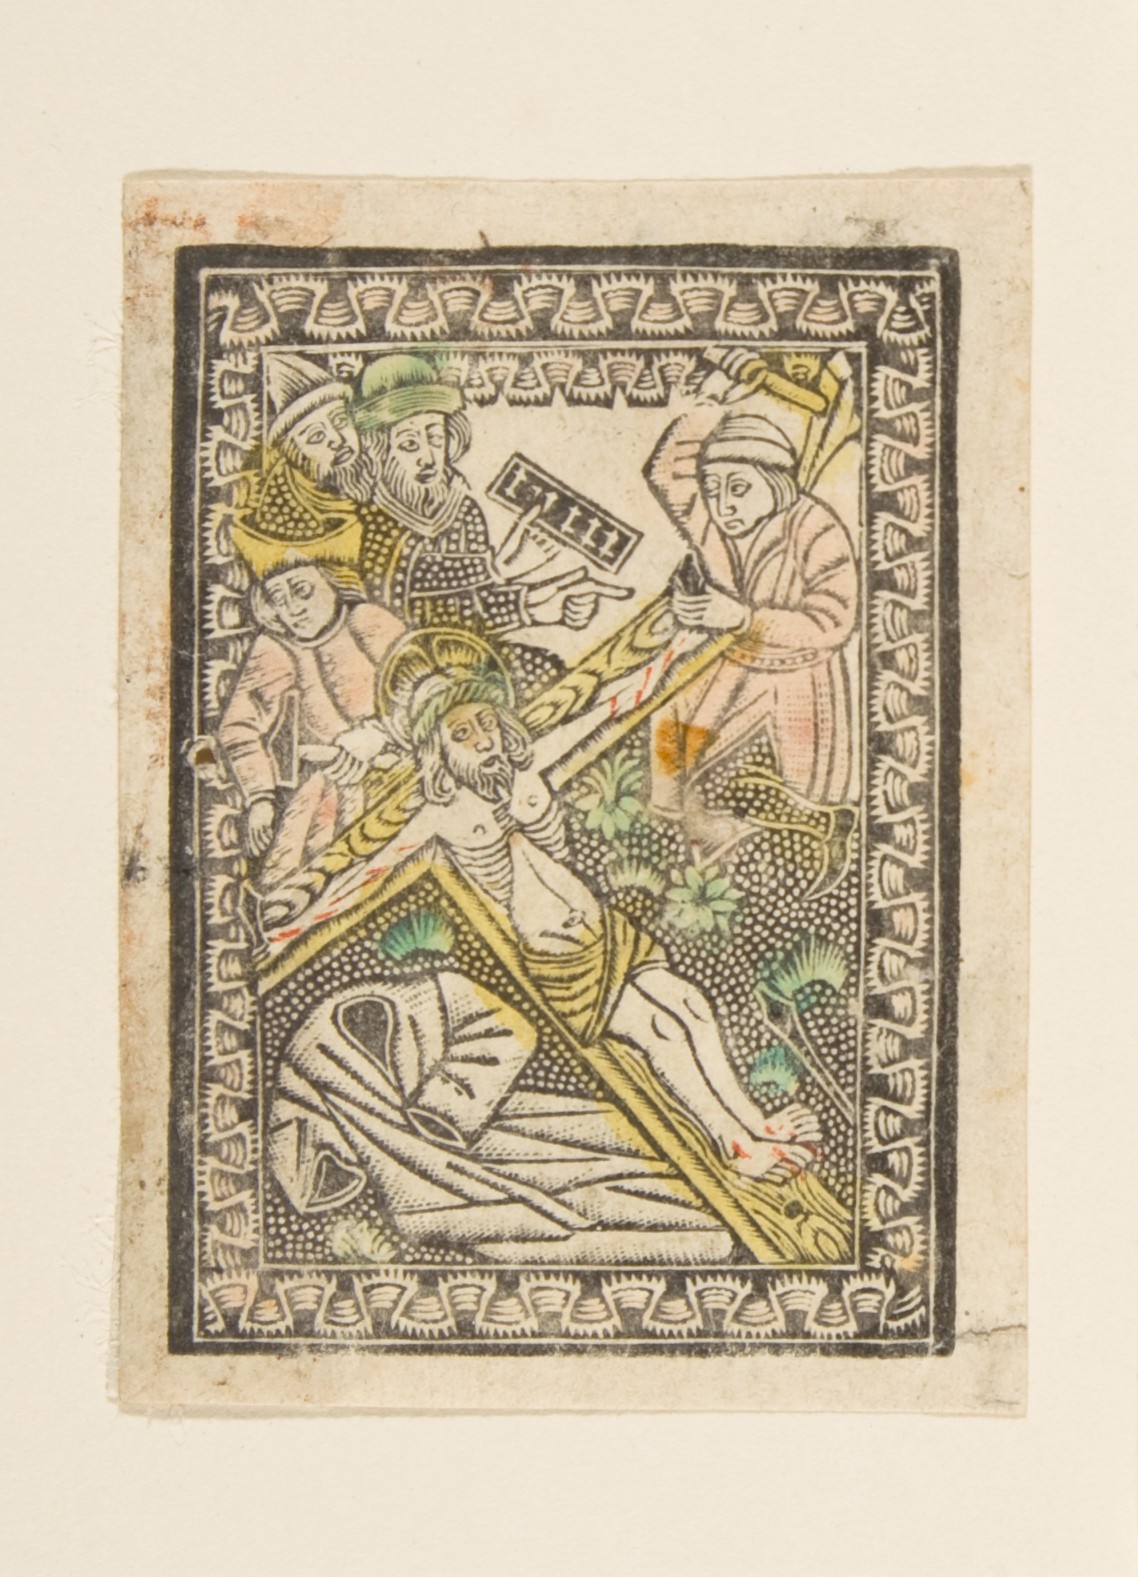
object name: print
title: Christ Nailed to the Cross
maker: anonymous, german, 15th century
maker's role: artist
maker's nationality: german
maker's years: 1400-1500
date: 1401-1500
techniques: hand coloring, woodcut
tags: men,christ,crucifixion